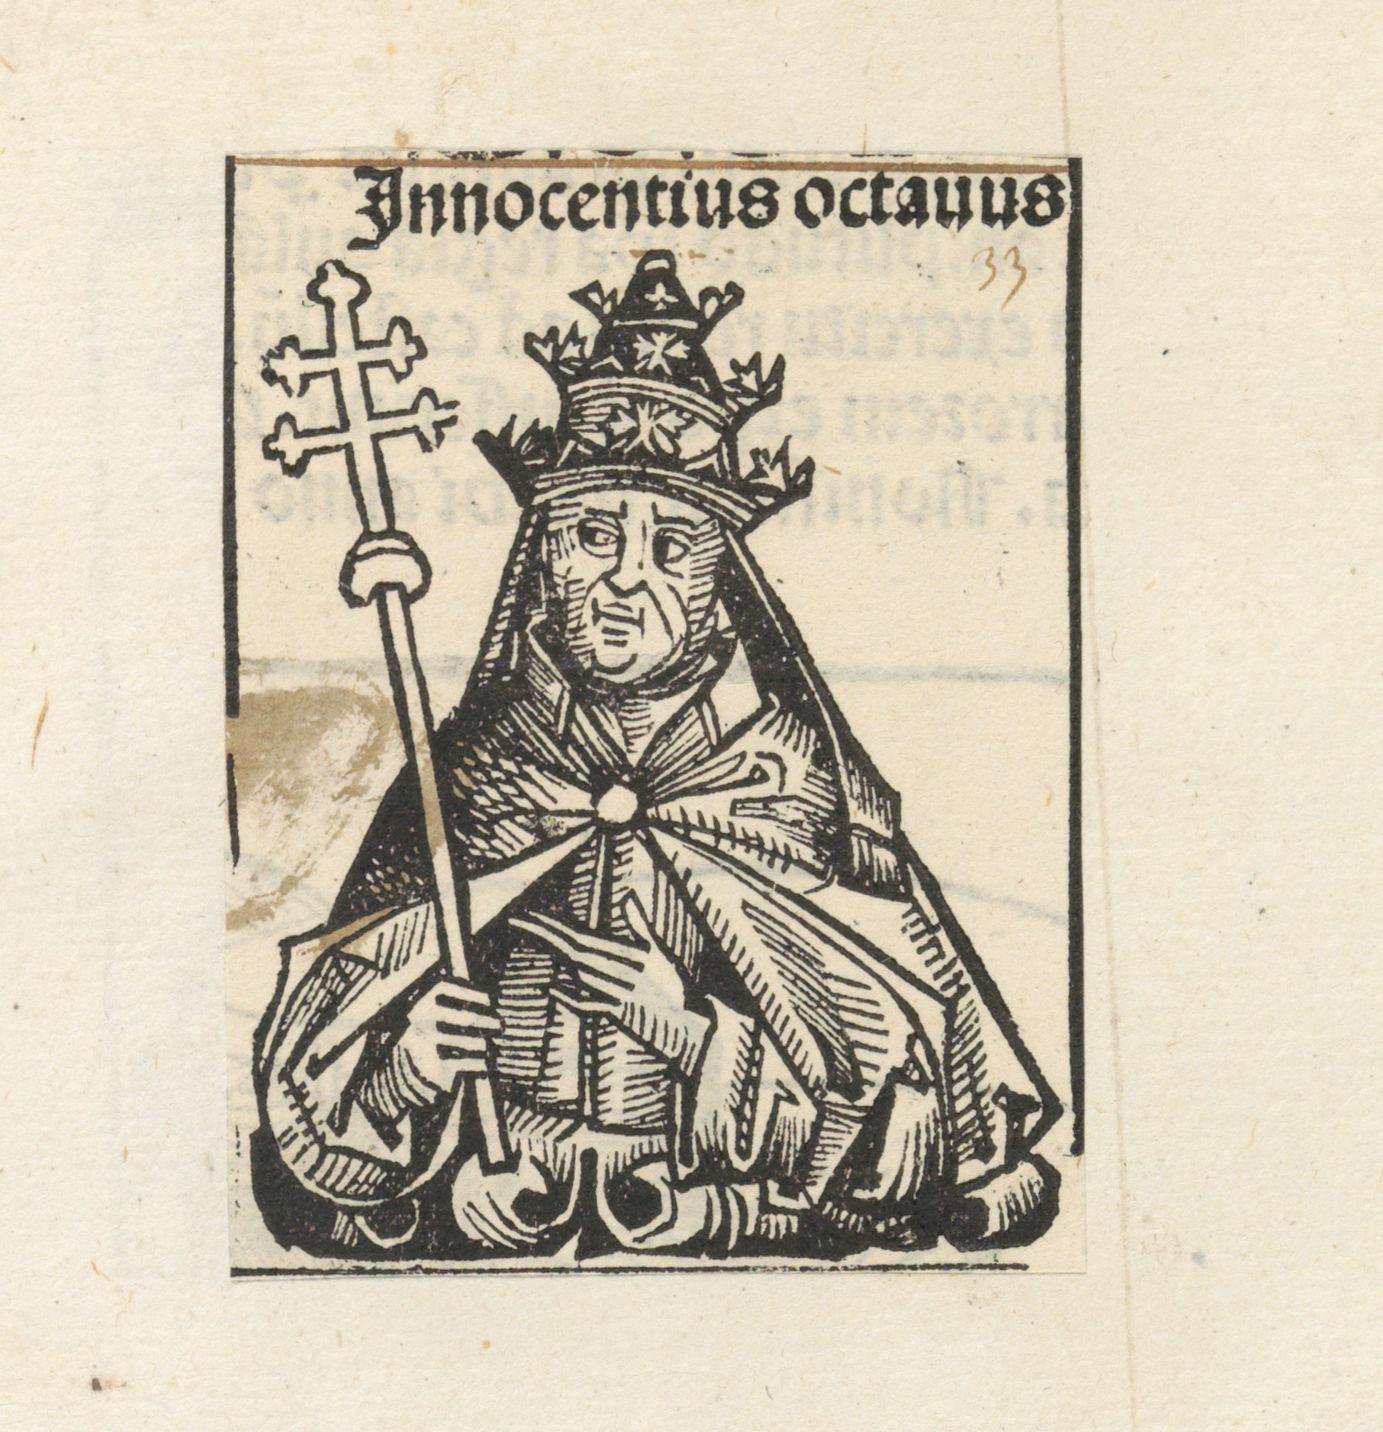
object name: book illustration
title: Liber Chronicarum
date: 1493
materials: paper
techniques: letterpress printing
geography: nuremberg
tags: rome, pope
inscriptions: inscription: ‘33’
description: Een bloemkelk met een paus. Hij draagt een tiara en heeft een staf met een dubbel kruis in zijn handen. De voorstelling is onderdeel van de opeenvolging pausen in de Liber Chronicarum. De tekst identificeert de man als Innocentius VIII. De prent maakt deel uit van een album.